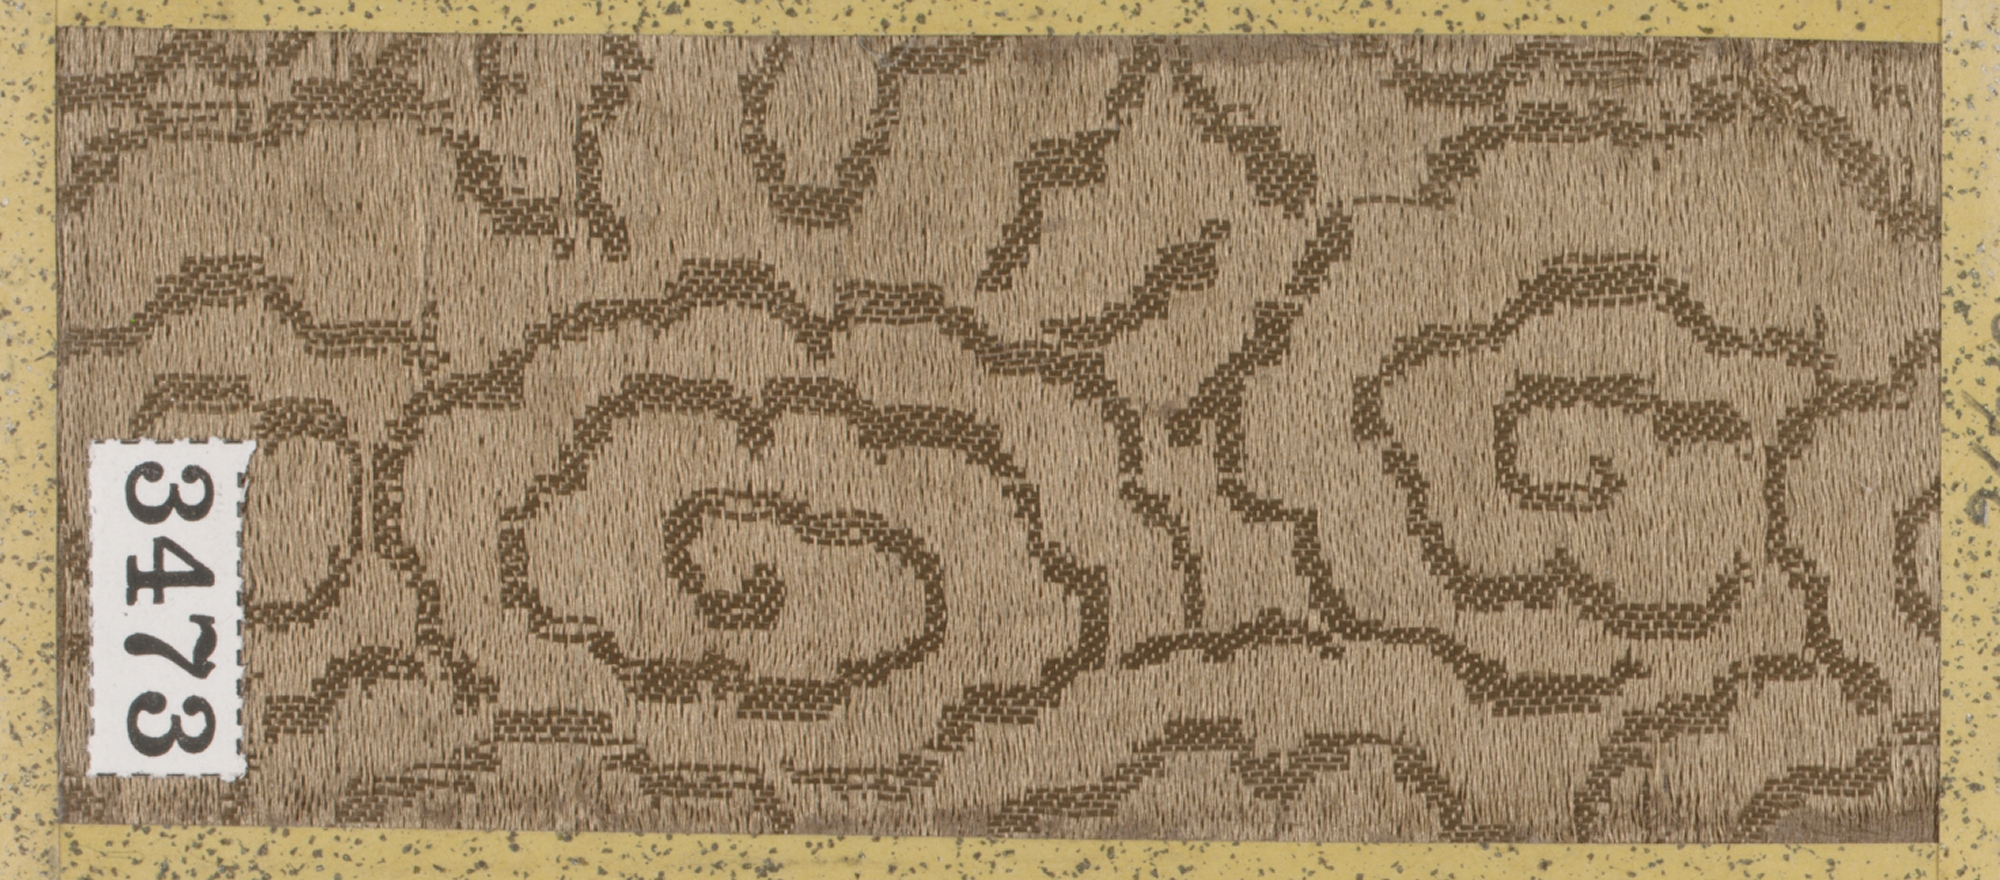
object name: sample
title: Textile Sample from Sample Book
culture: japanese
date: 1801-1900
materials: silk